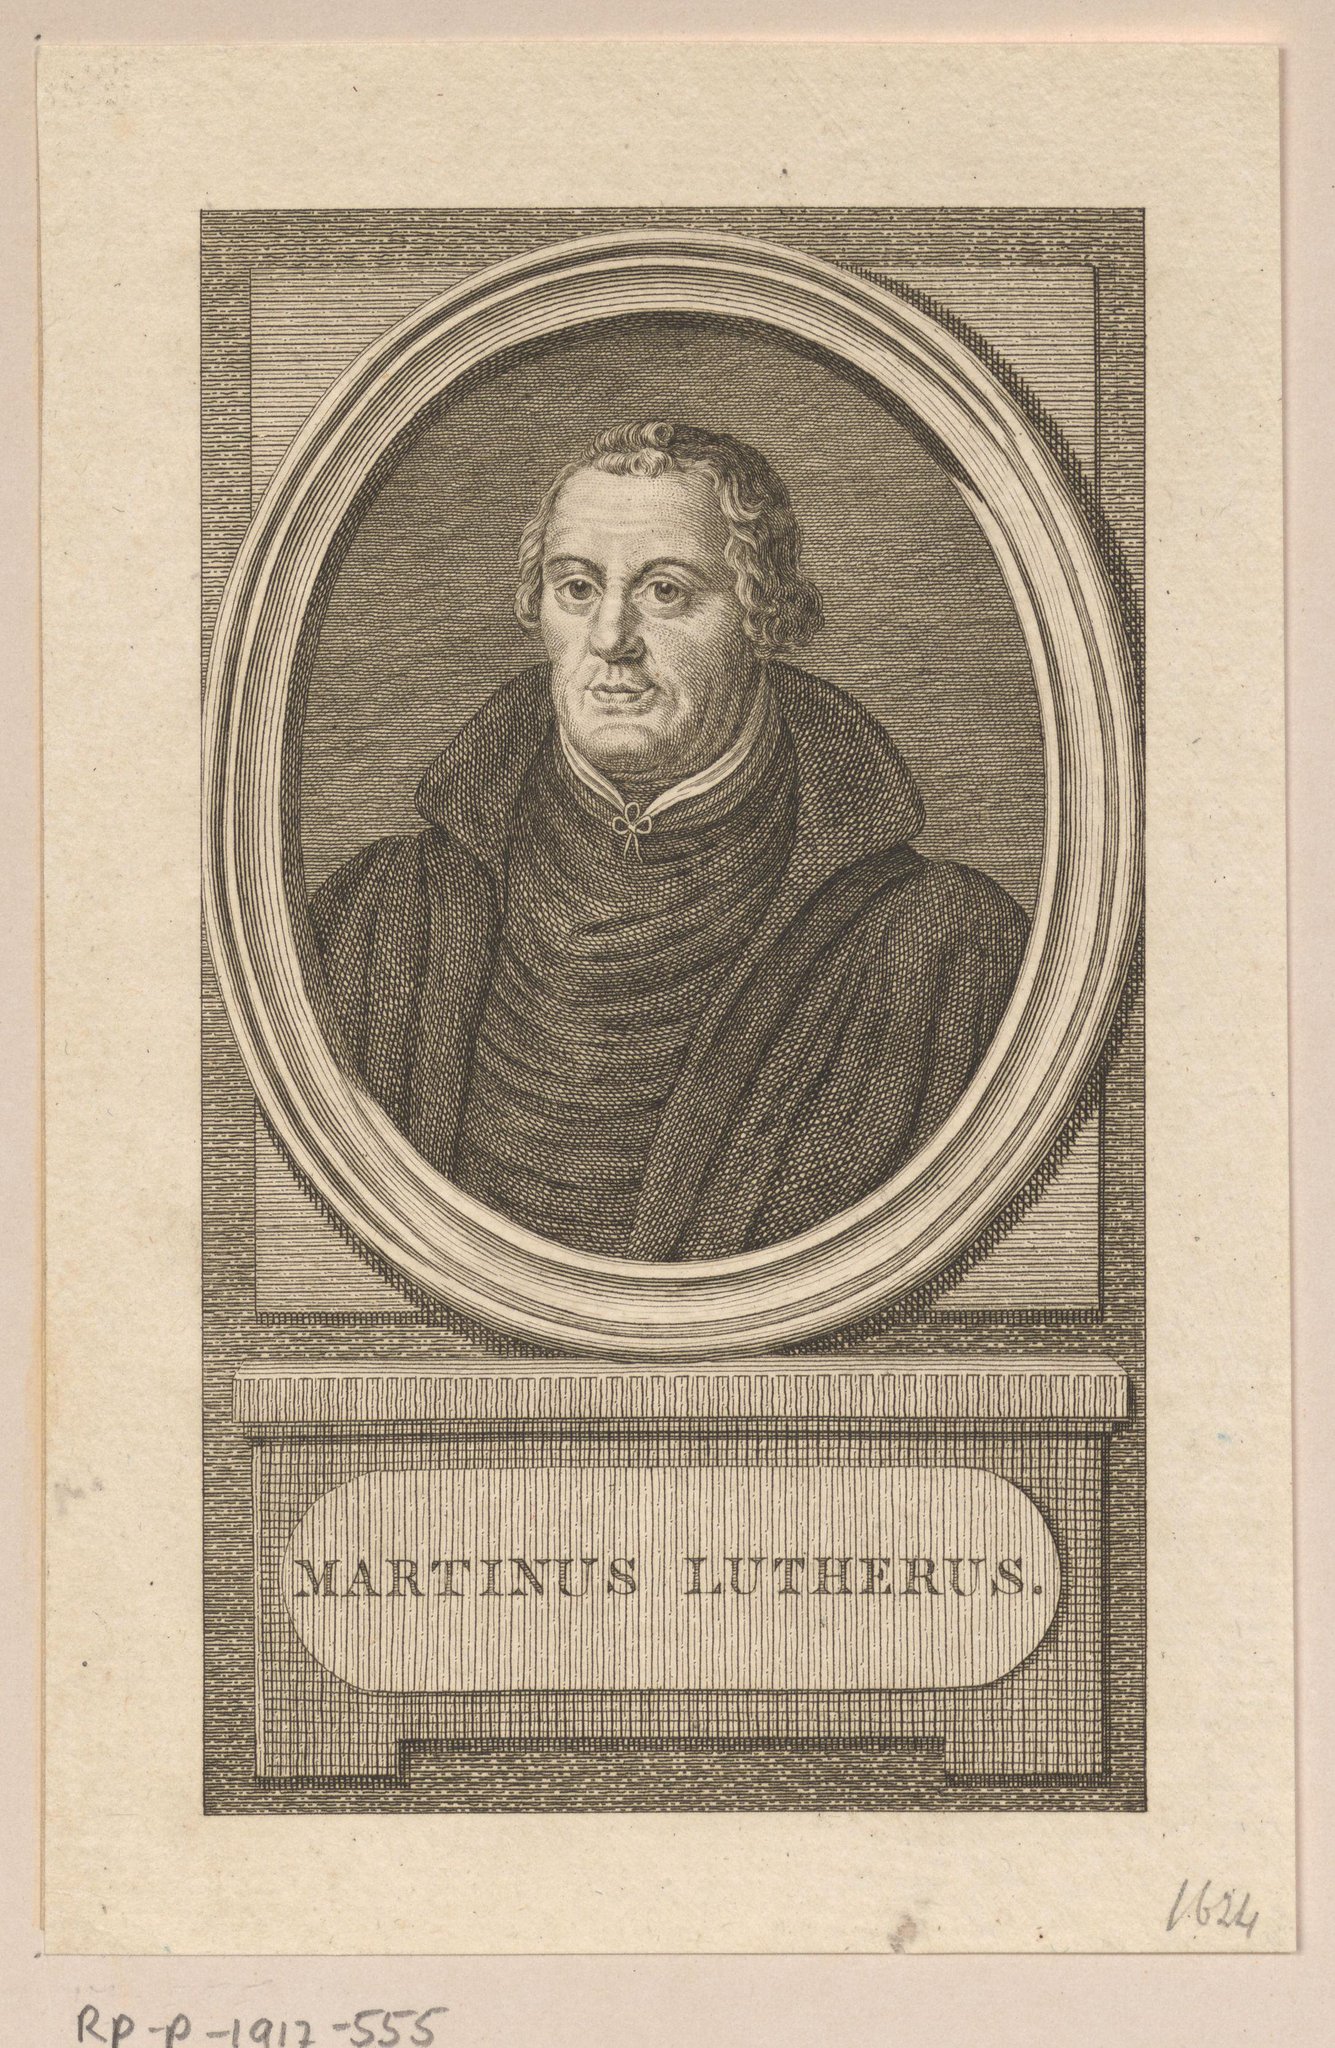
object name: print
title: Portret van Martin Luther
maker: Anonymous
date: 1700-1799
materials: paper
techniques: etching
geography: low countries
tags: priest, martin luther, theologian, historical persons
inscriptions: collector's mark: Lugt 2228